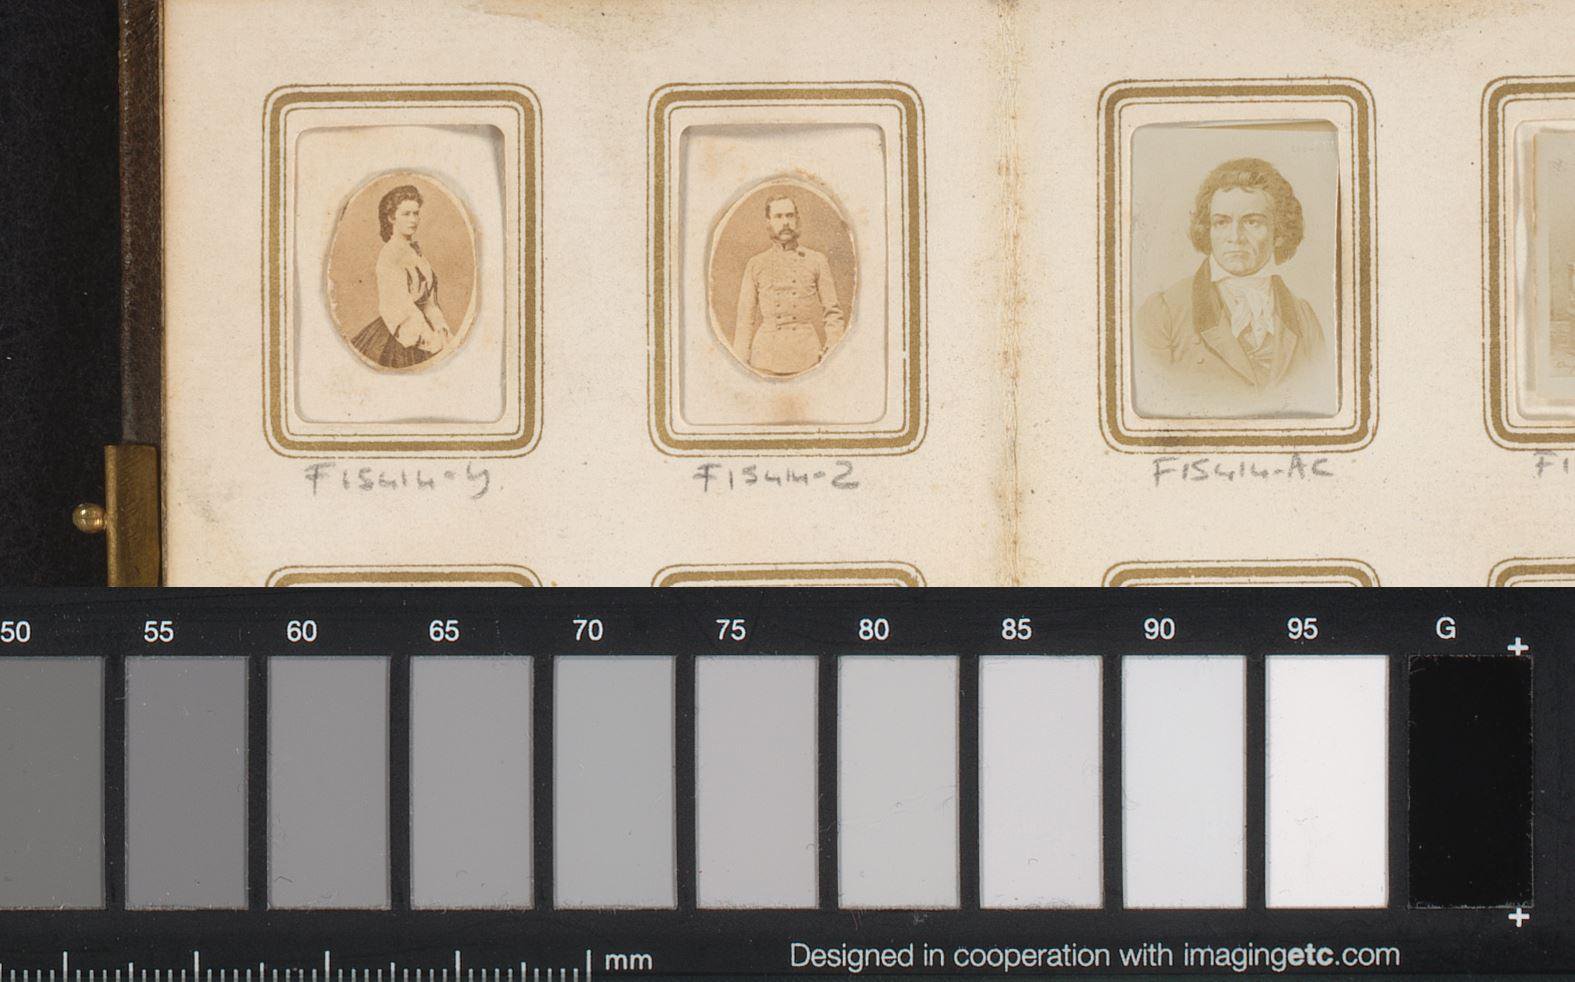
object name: album leaf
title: Miniatuurportret van Frans Jozef I van Oostenrijk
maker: Anonymous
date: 1851-1900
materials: paper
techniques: albumen print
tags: vienna, emperor